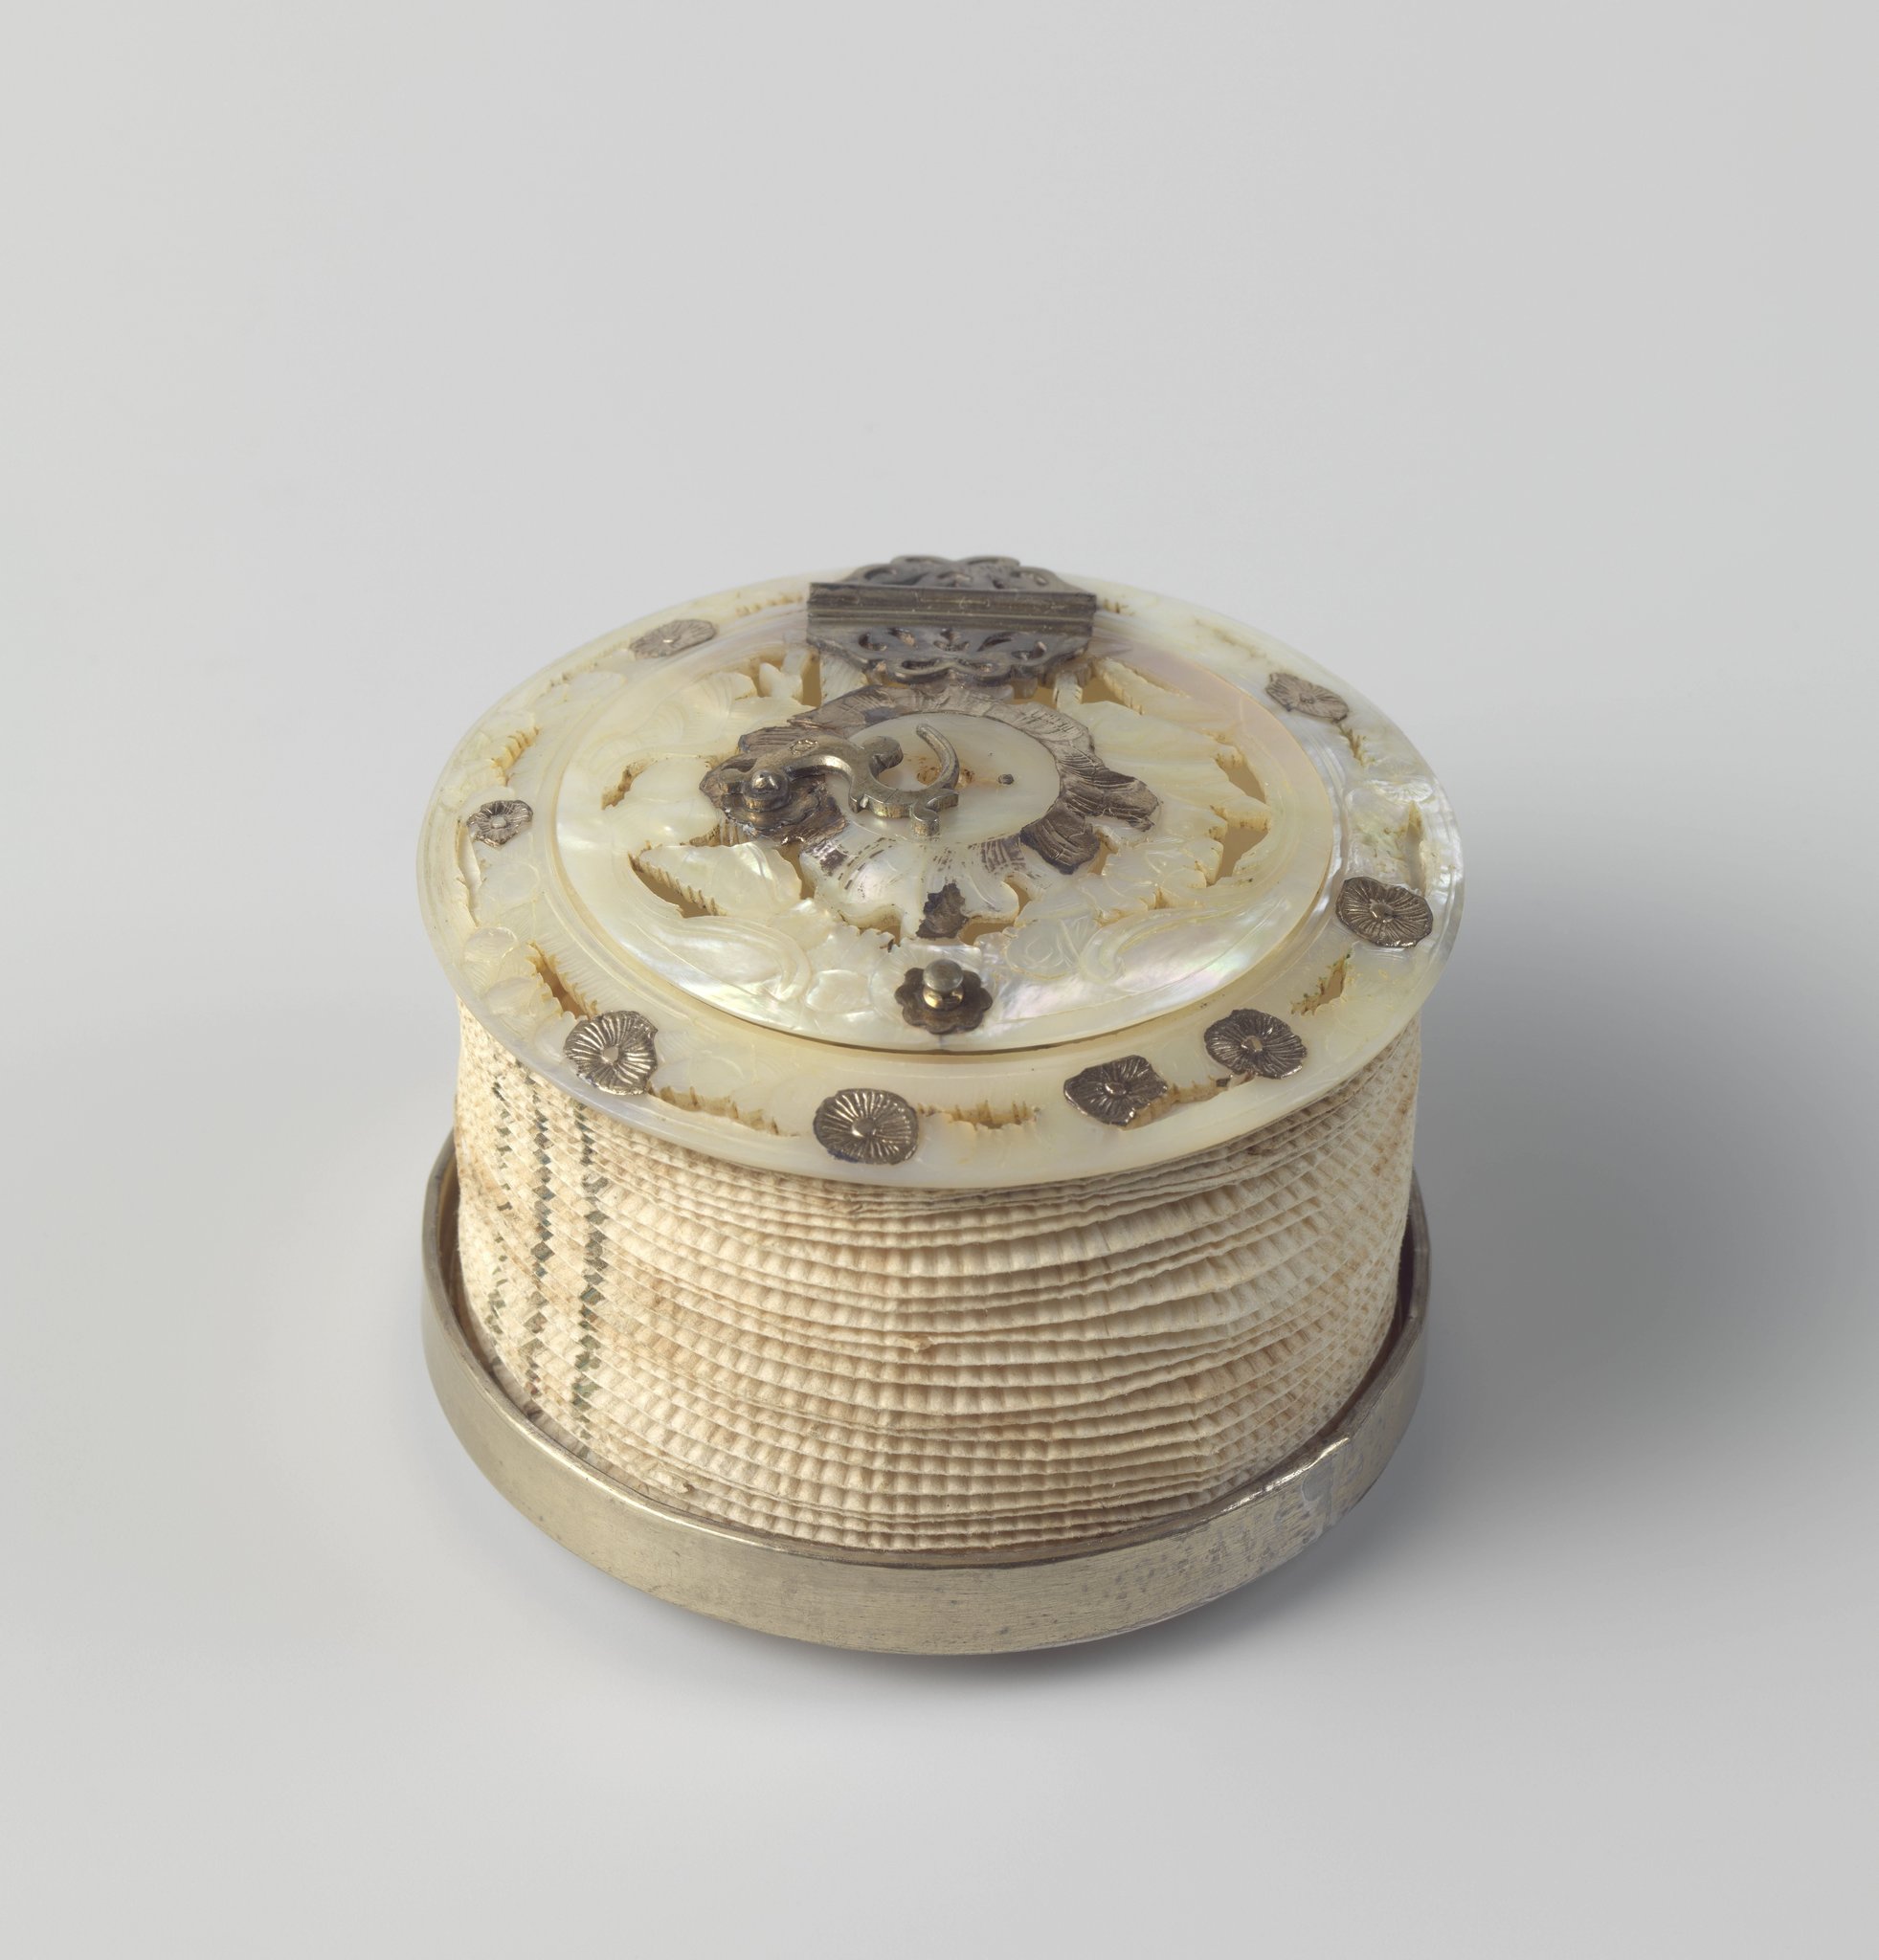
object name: lantern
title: Lantaarn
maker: Anonymous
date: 1750-1756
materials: mother of pearl, paper, silver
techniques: gilding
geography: paris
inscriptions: countermark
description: Een ivoren lantaarn met een parelmoeren opengewerkte deksel en bodem. Gemerkt.